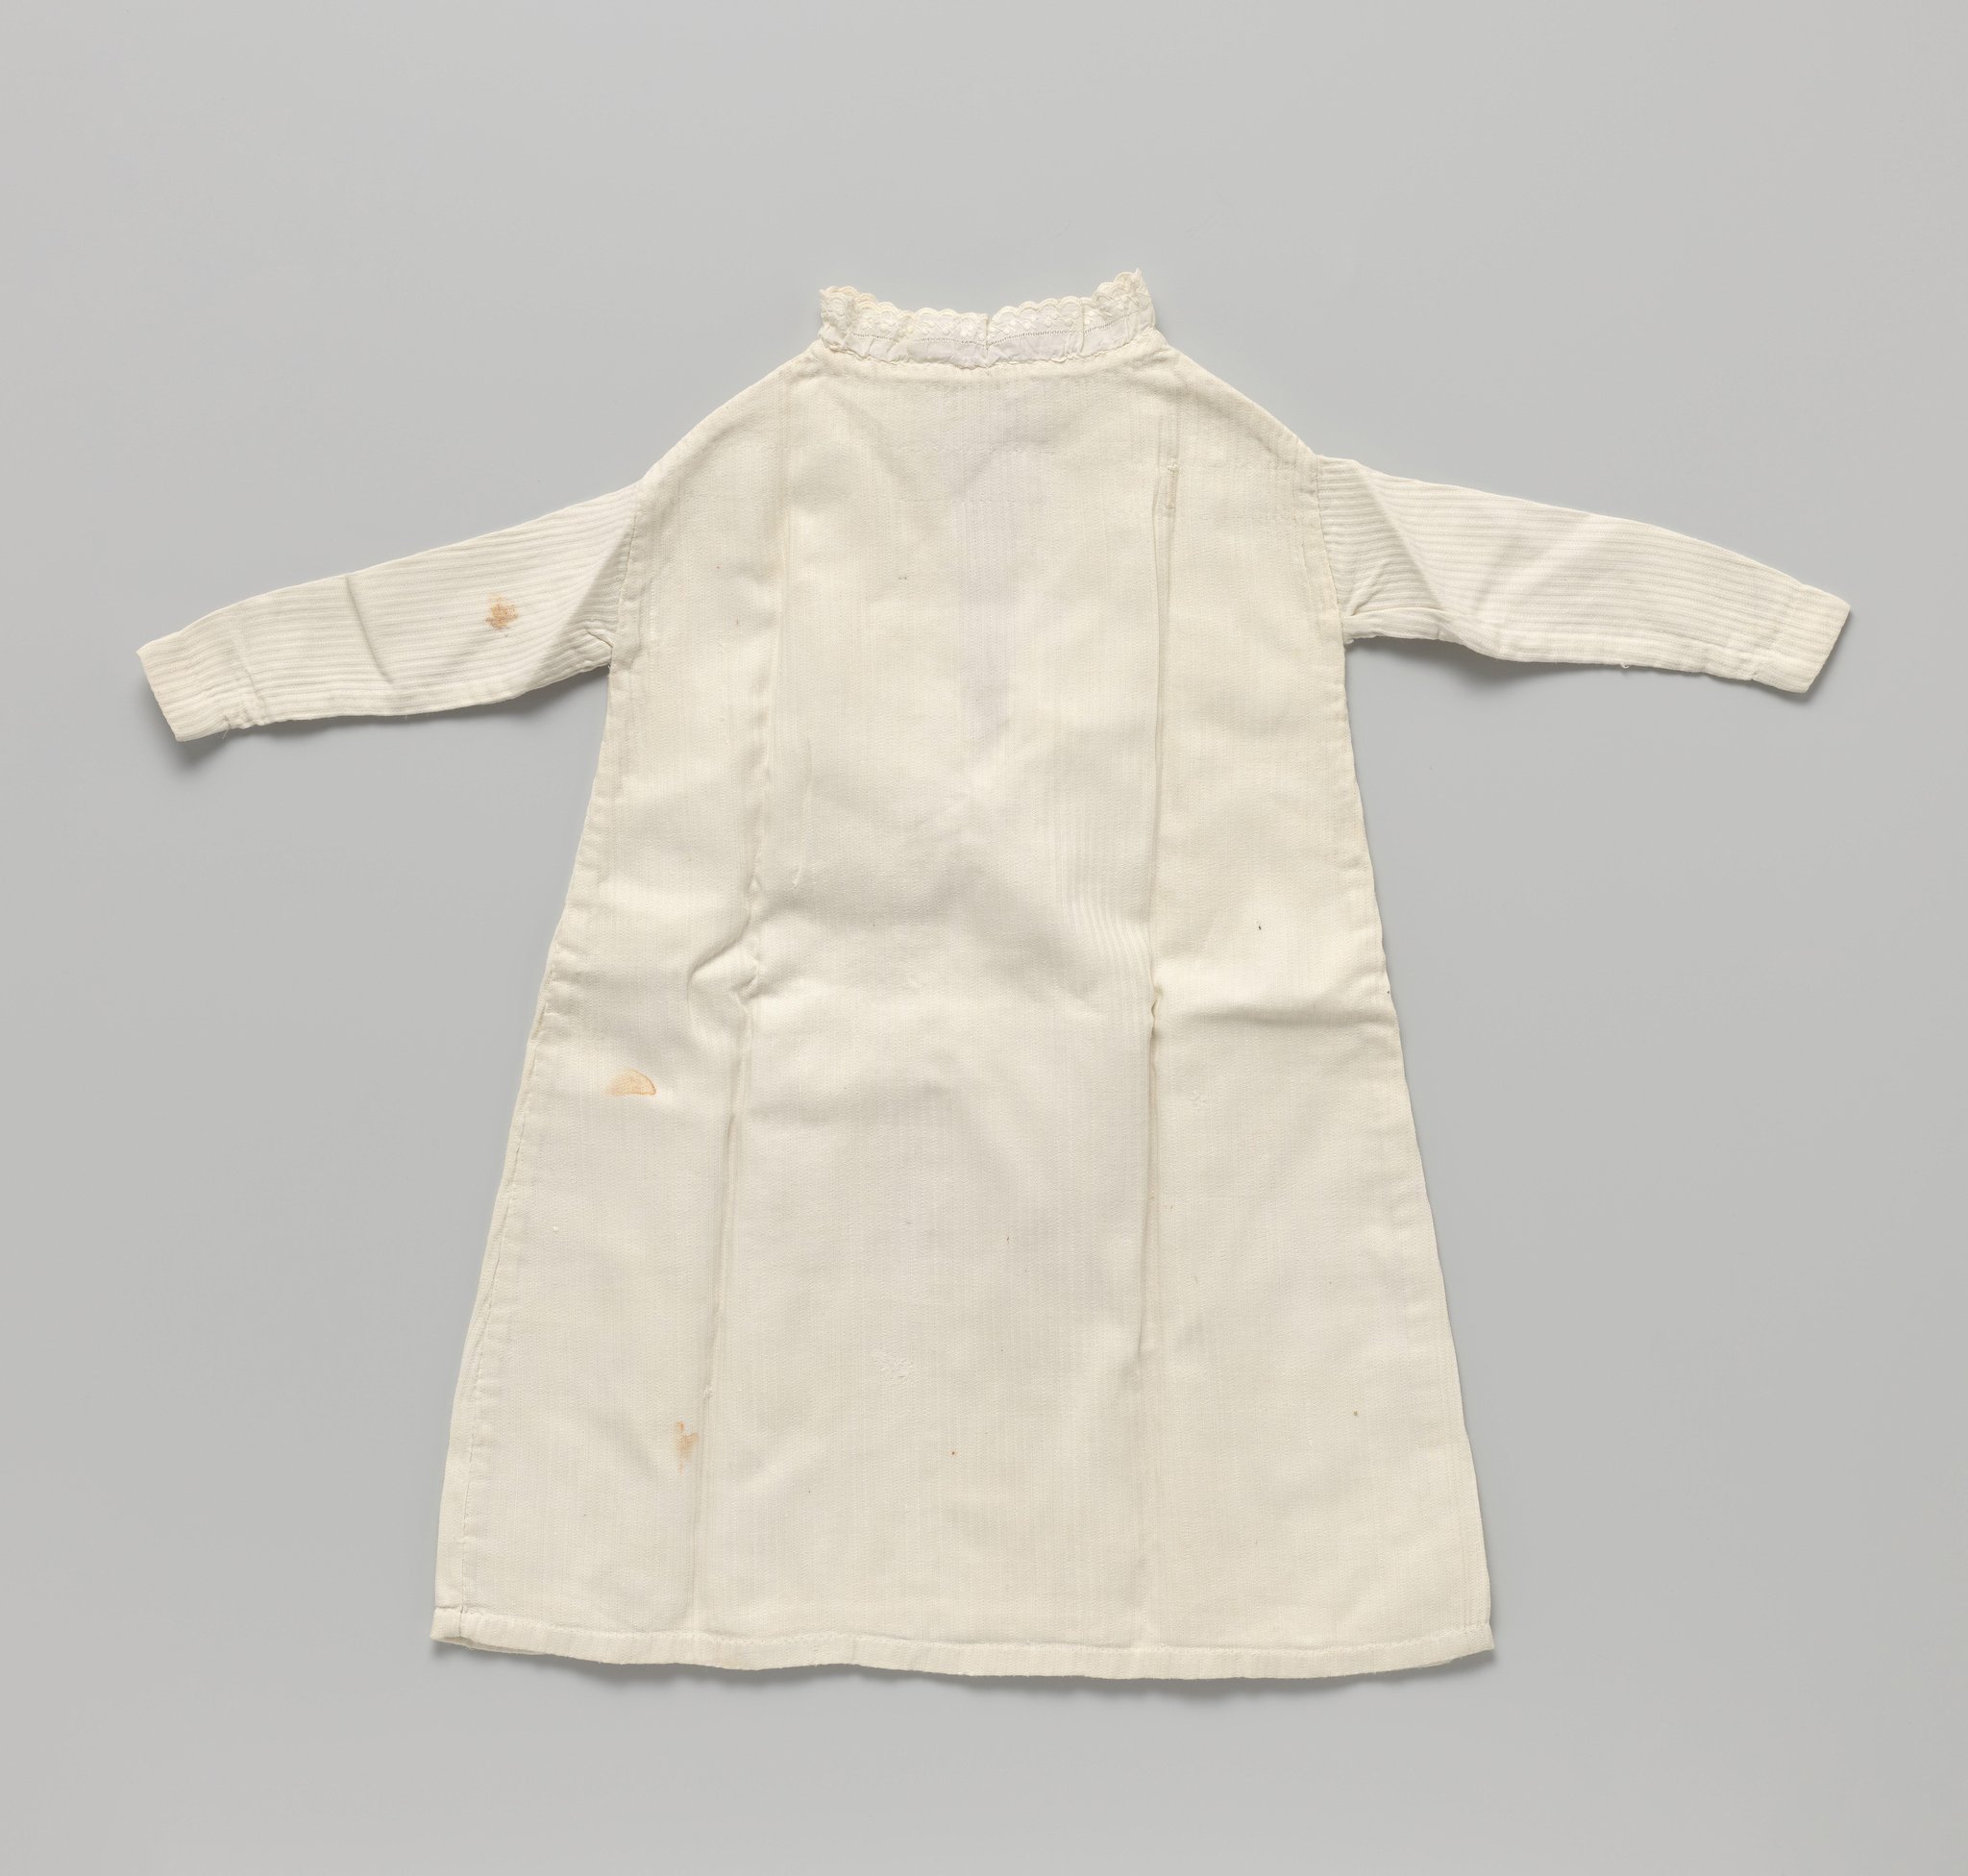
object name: doll's clothing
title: Witte jurk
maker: Anonymous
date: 1850-1920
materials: textile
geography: netherlands